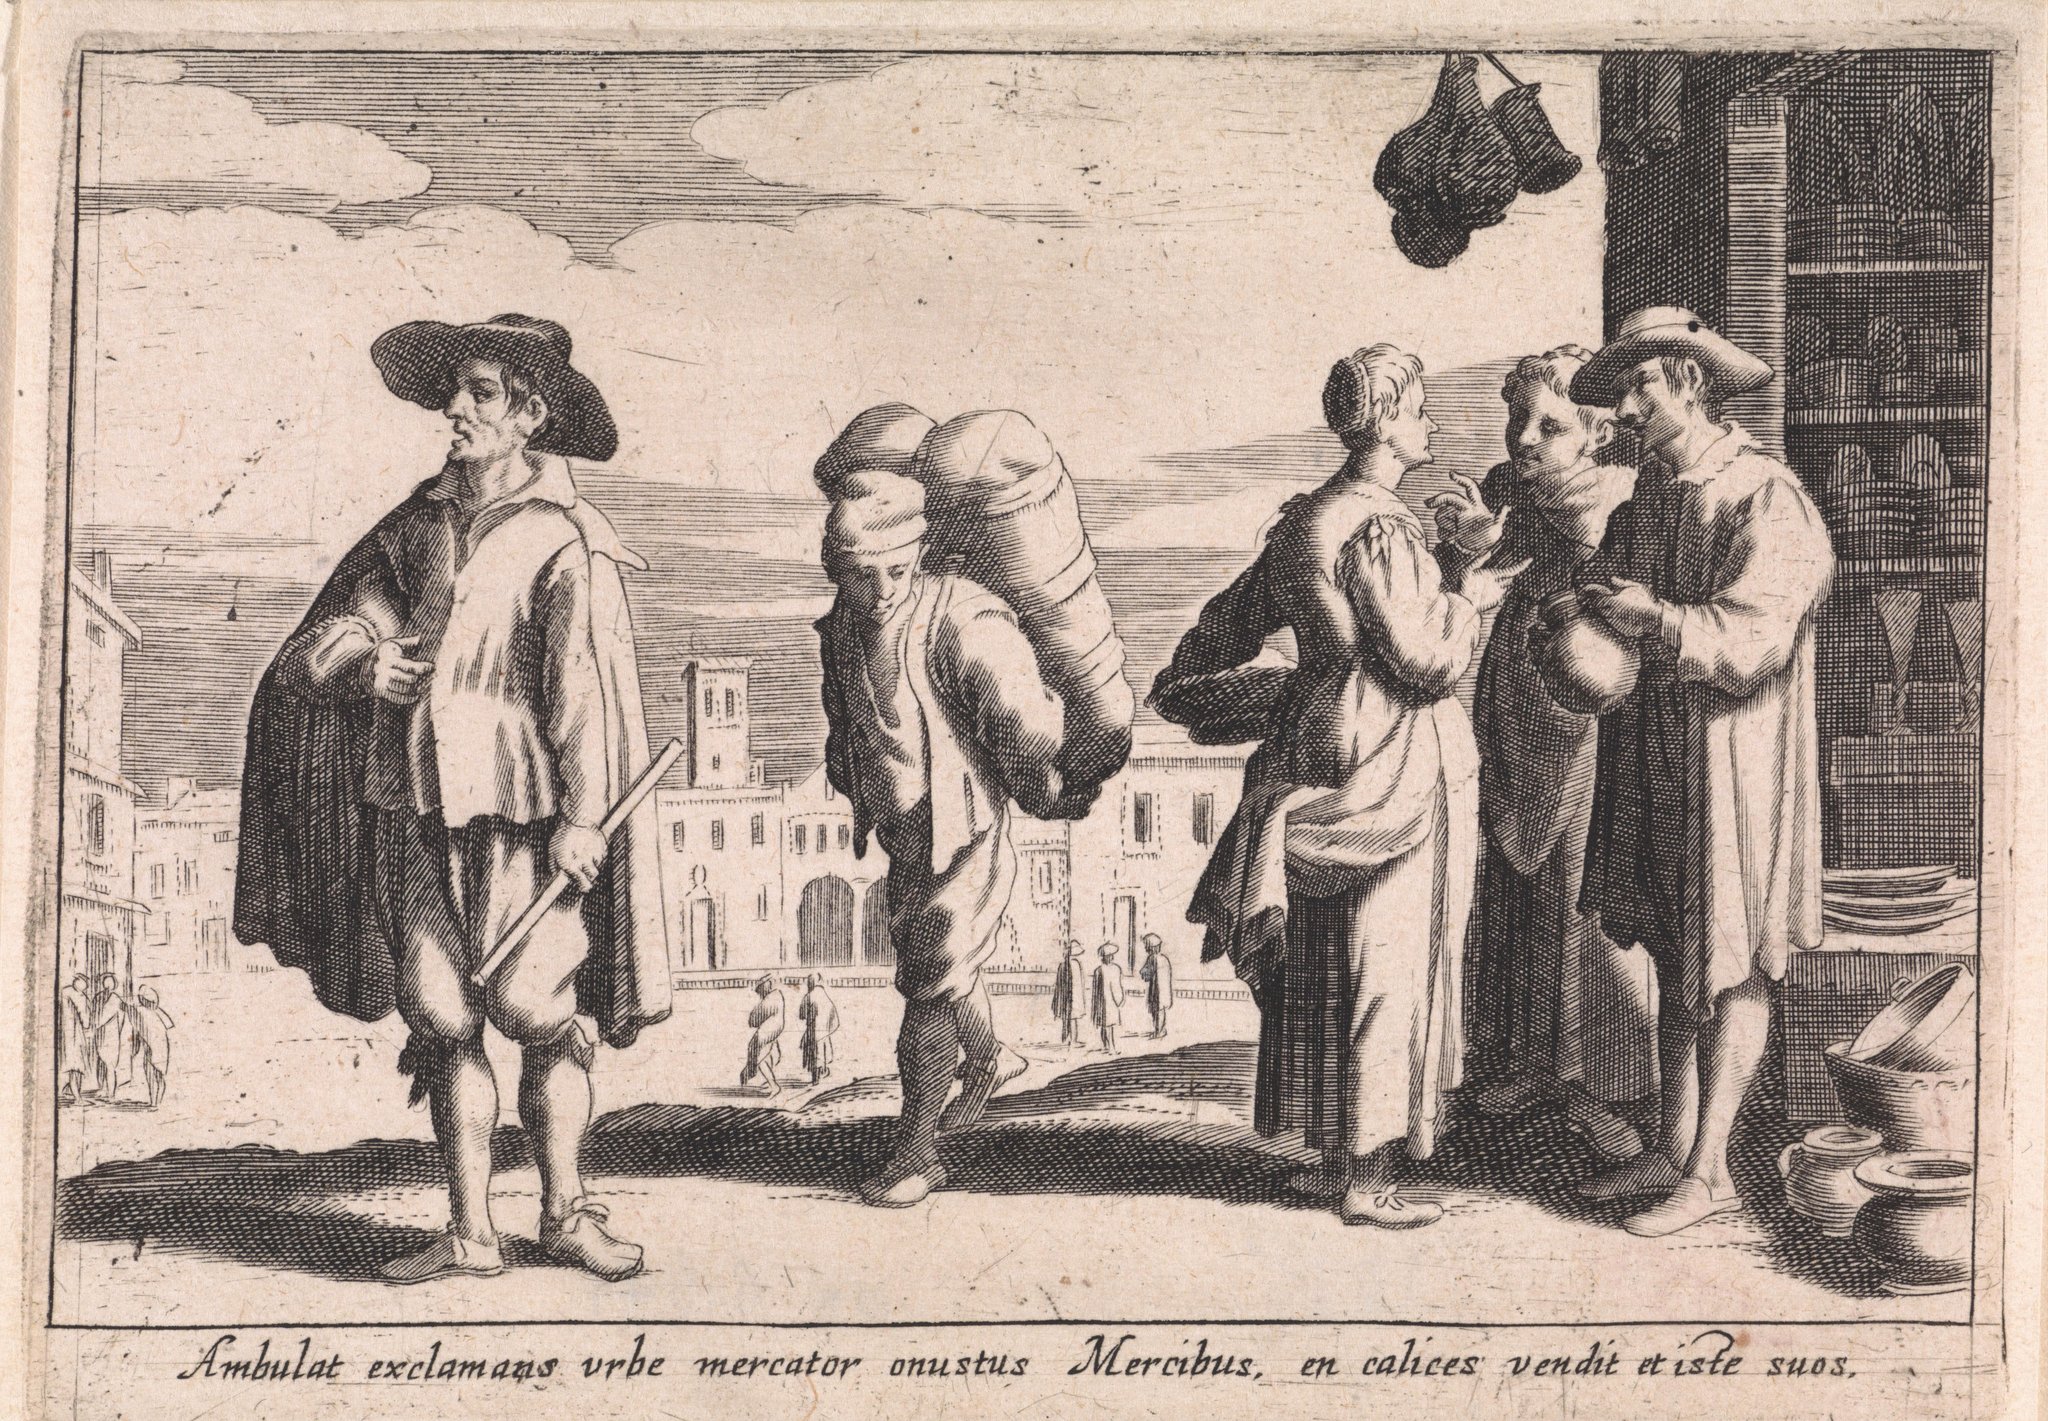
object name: print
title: Verkoper van aardewerk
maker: Anonymous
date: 1613-1667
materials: paper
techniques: engraving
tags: container of ceramics: jar, jug, pot, vase, merchant, salesman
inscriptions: collector's mark: Lugt 240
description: Een verkoper van aardewerk is in gesprek met een vrouw. De planken in zijn winkel staan vol met potten en schalen. Links loopt een knecht met een pakket op zijn rug achter een man aan. In de marge een onderschrift in het Latijn.